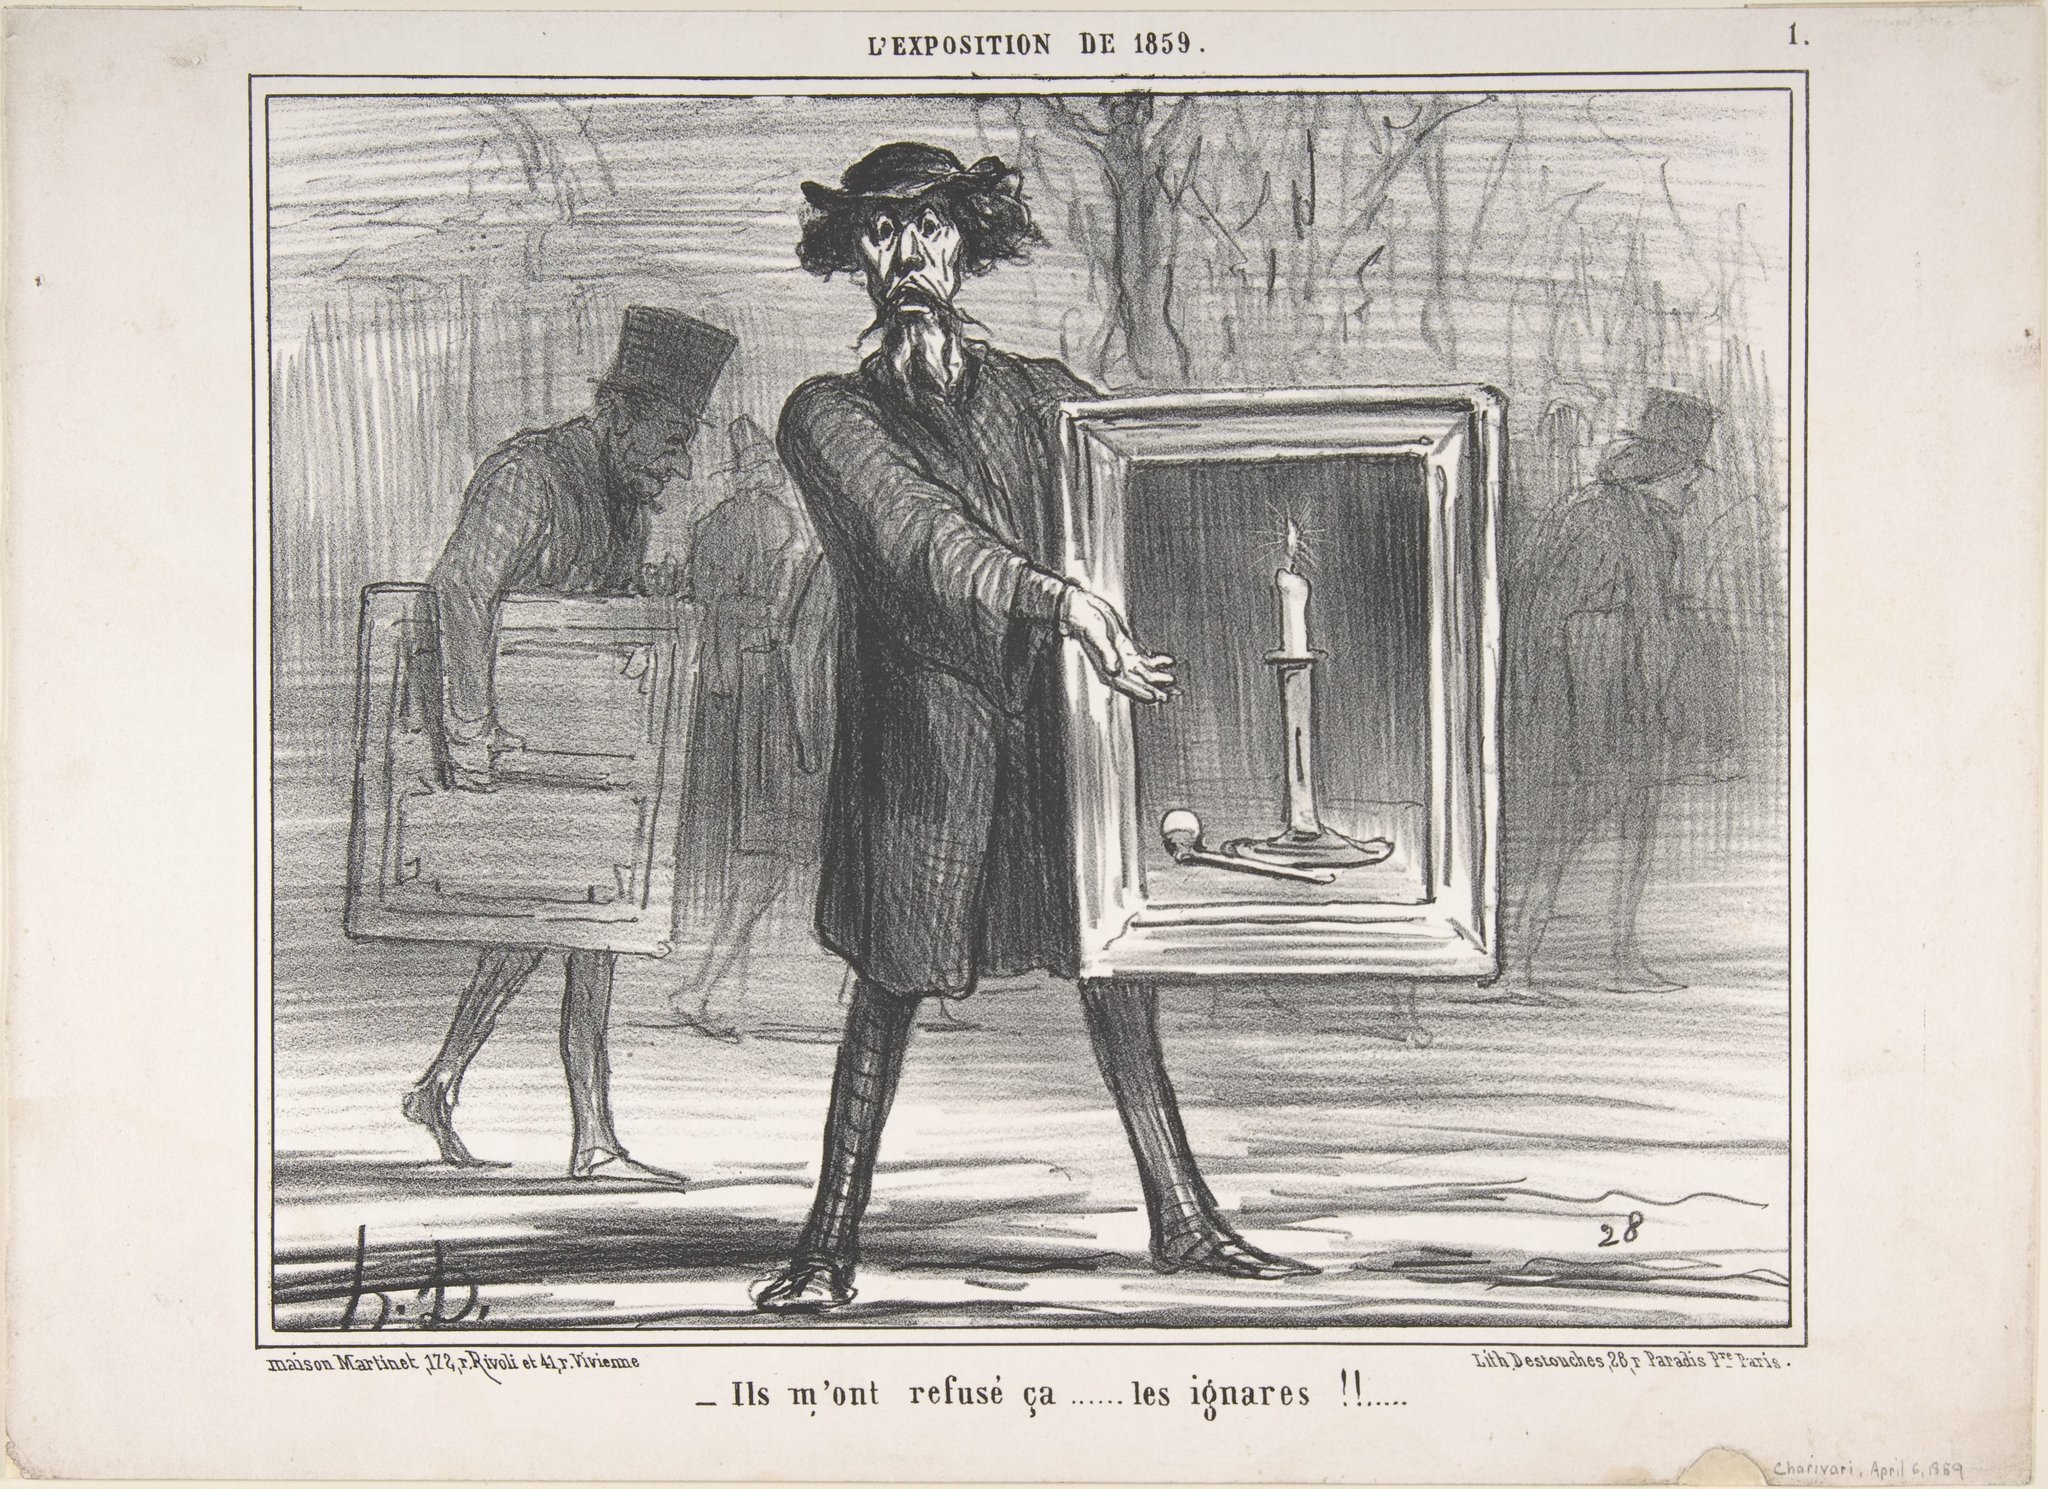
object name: print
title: They Refused This...the Ignoramuses!! (Ils m'ont refusé ça...les ignares!!), published in Le Charivari, April 6, 1859. From the series: L'Exposition de 1859.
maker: honoré daumier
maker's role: artist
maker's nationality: french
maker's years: 1808-1879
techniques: lithograph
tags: men,candles